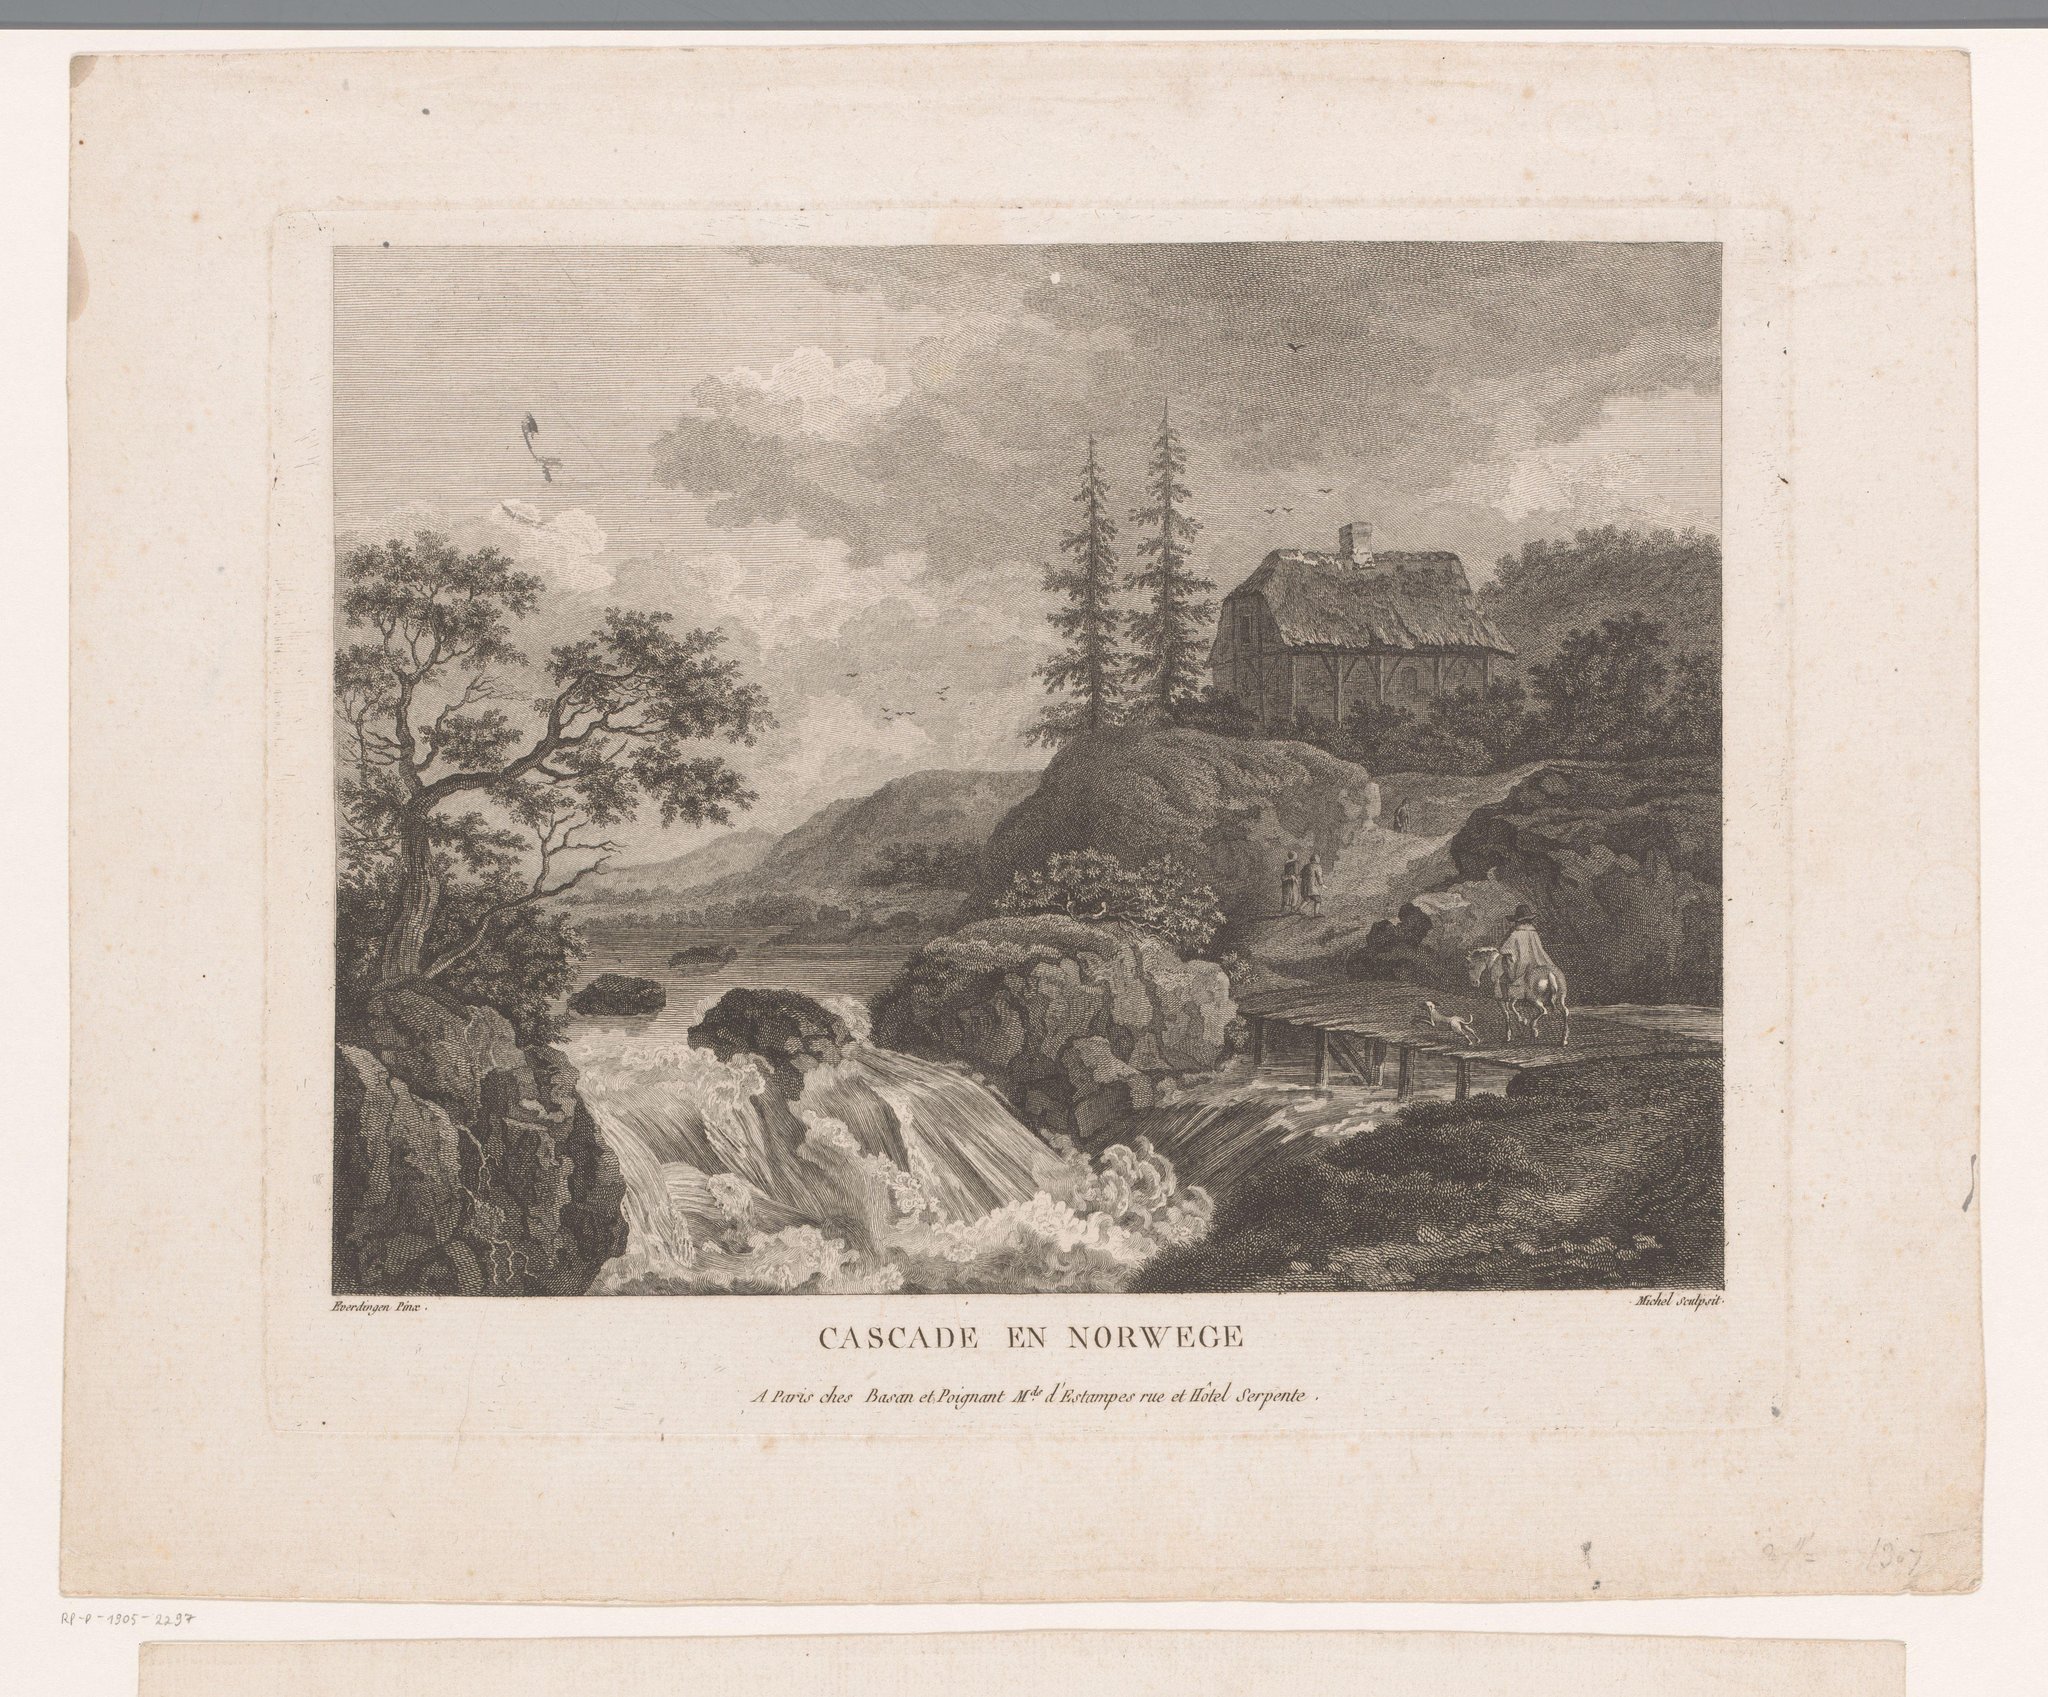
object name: print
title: Landschap met waterval in Noorwegen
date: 1773-1788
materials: paper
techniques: engraving, etching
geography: paris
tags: waterfall, norway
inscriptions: collector's mark: Lugt 2228